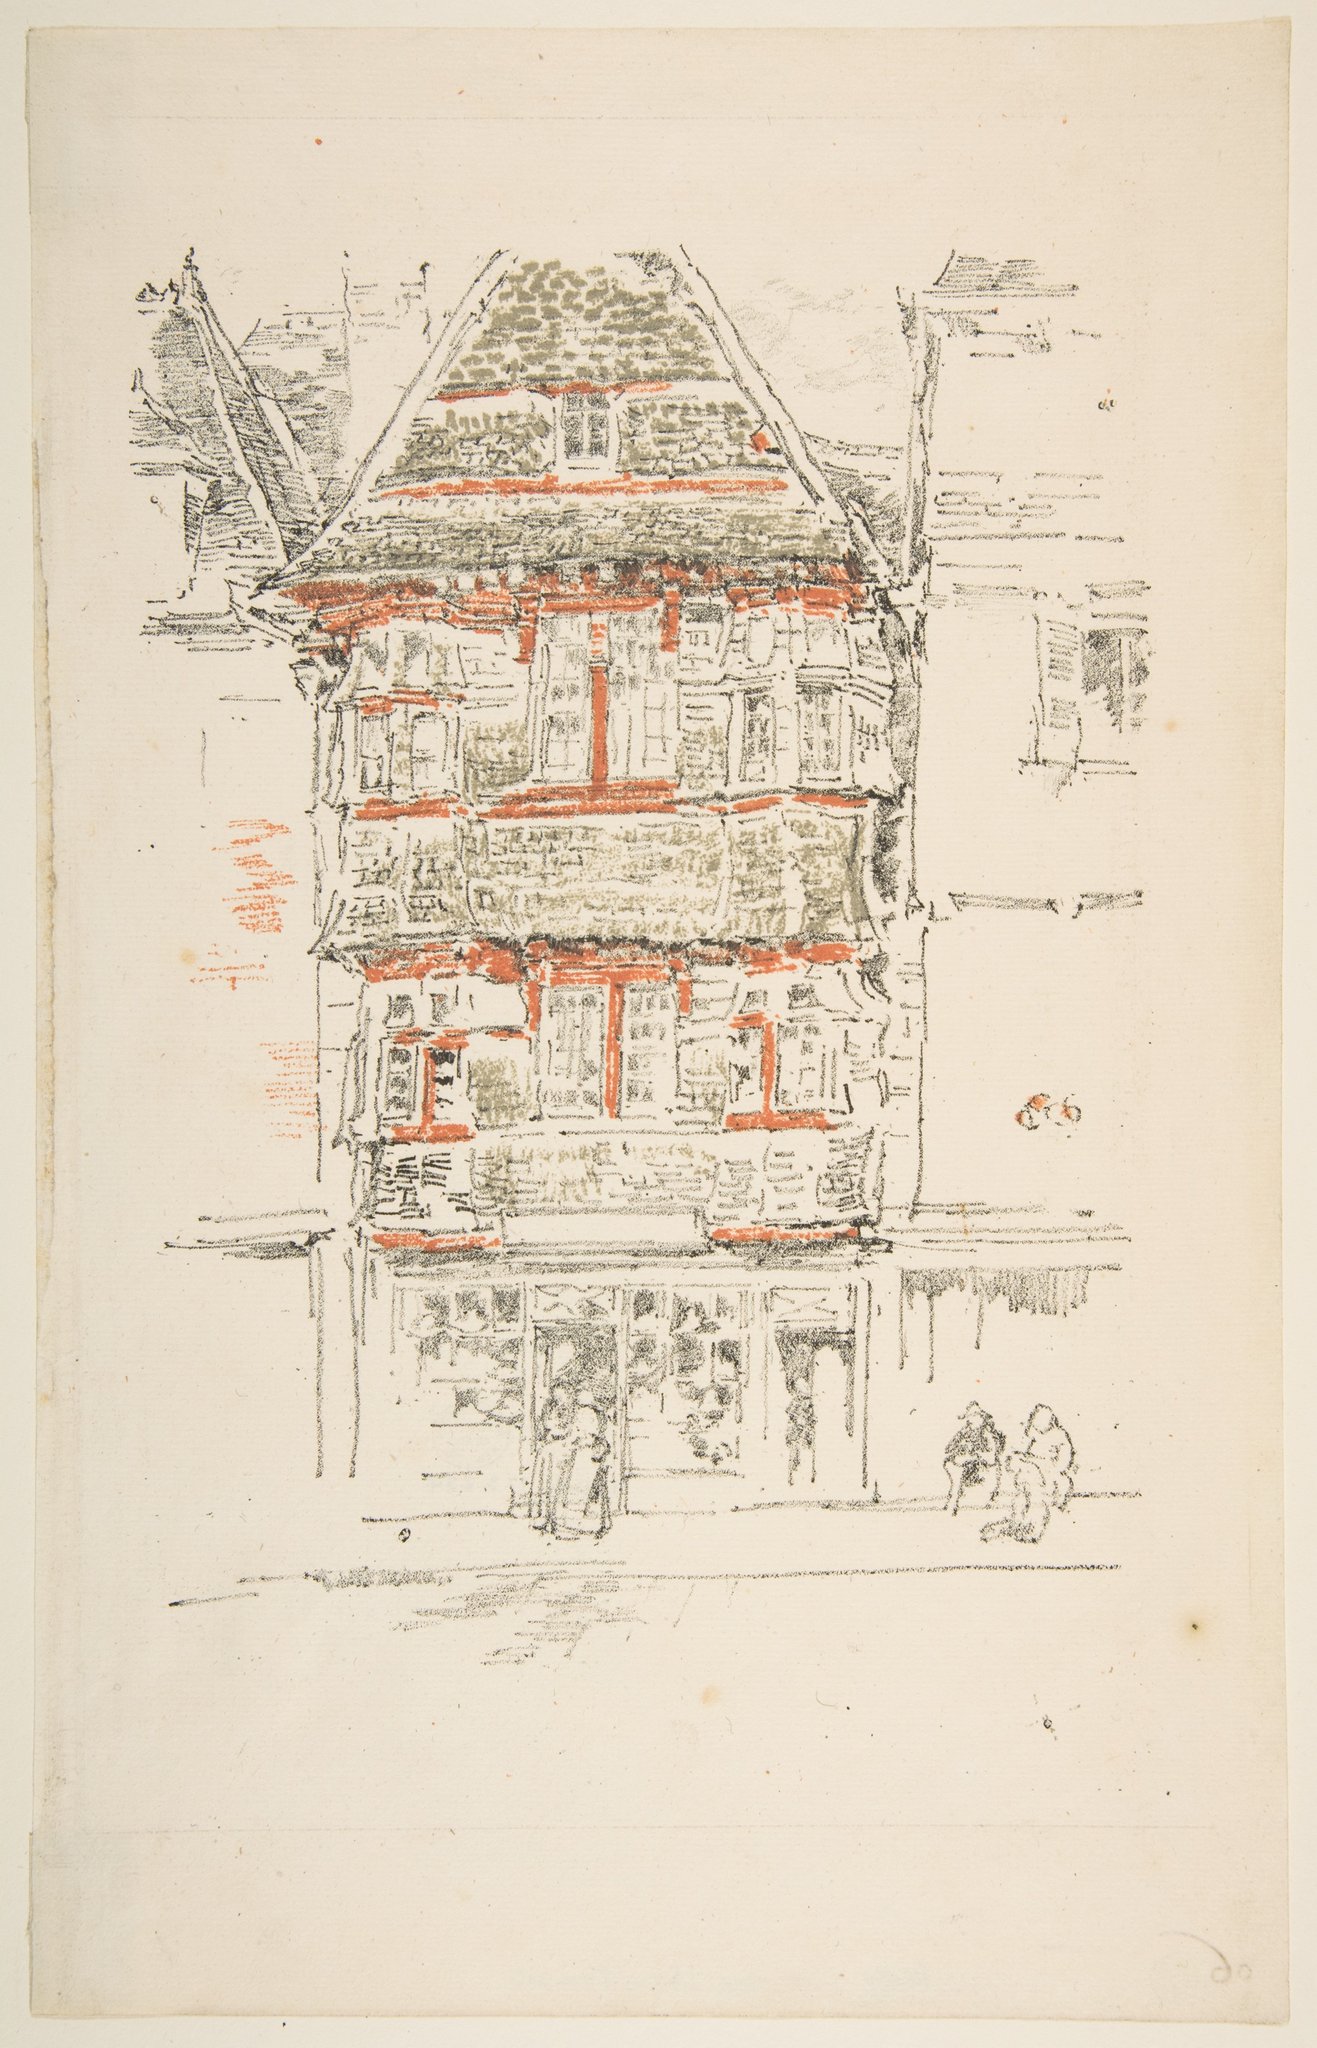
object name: print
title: Red House, Paimpol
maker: james mcneill whistler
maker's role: artist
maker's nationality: american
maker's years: 1834-1903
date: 1893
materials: paper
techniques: printing, scraping, lithography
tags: houses